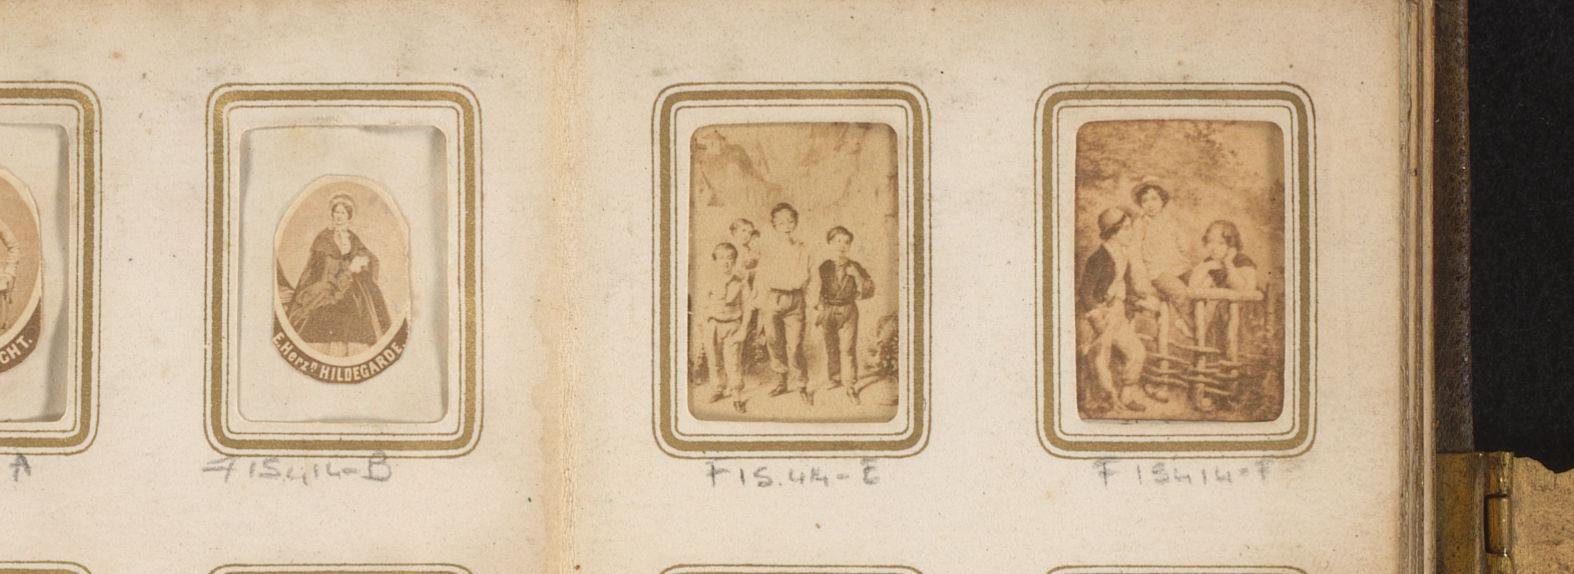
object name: reproduction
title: Fotoreproductie van vier onbekende kinderen in een berggebied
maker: Anonymous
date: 1851-1900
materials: paper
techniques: albumen print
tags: boy (child between toddler and youth), girl (child between toddler and youth)